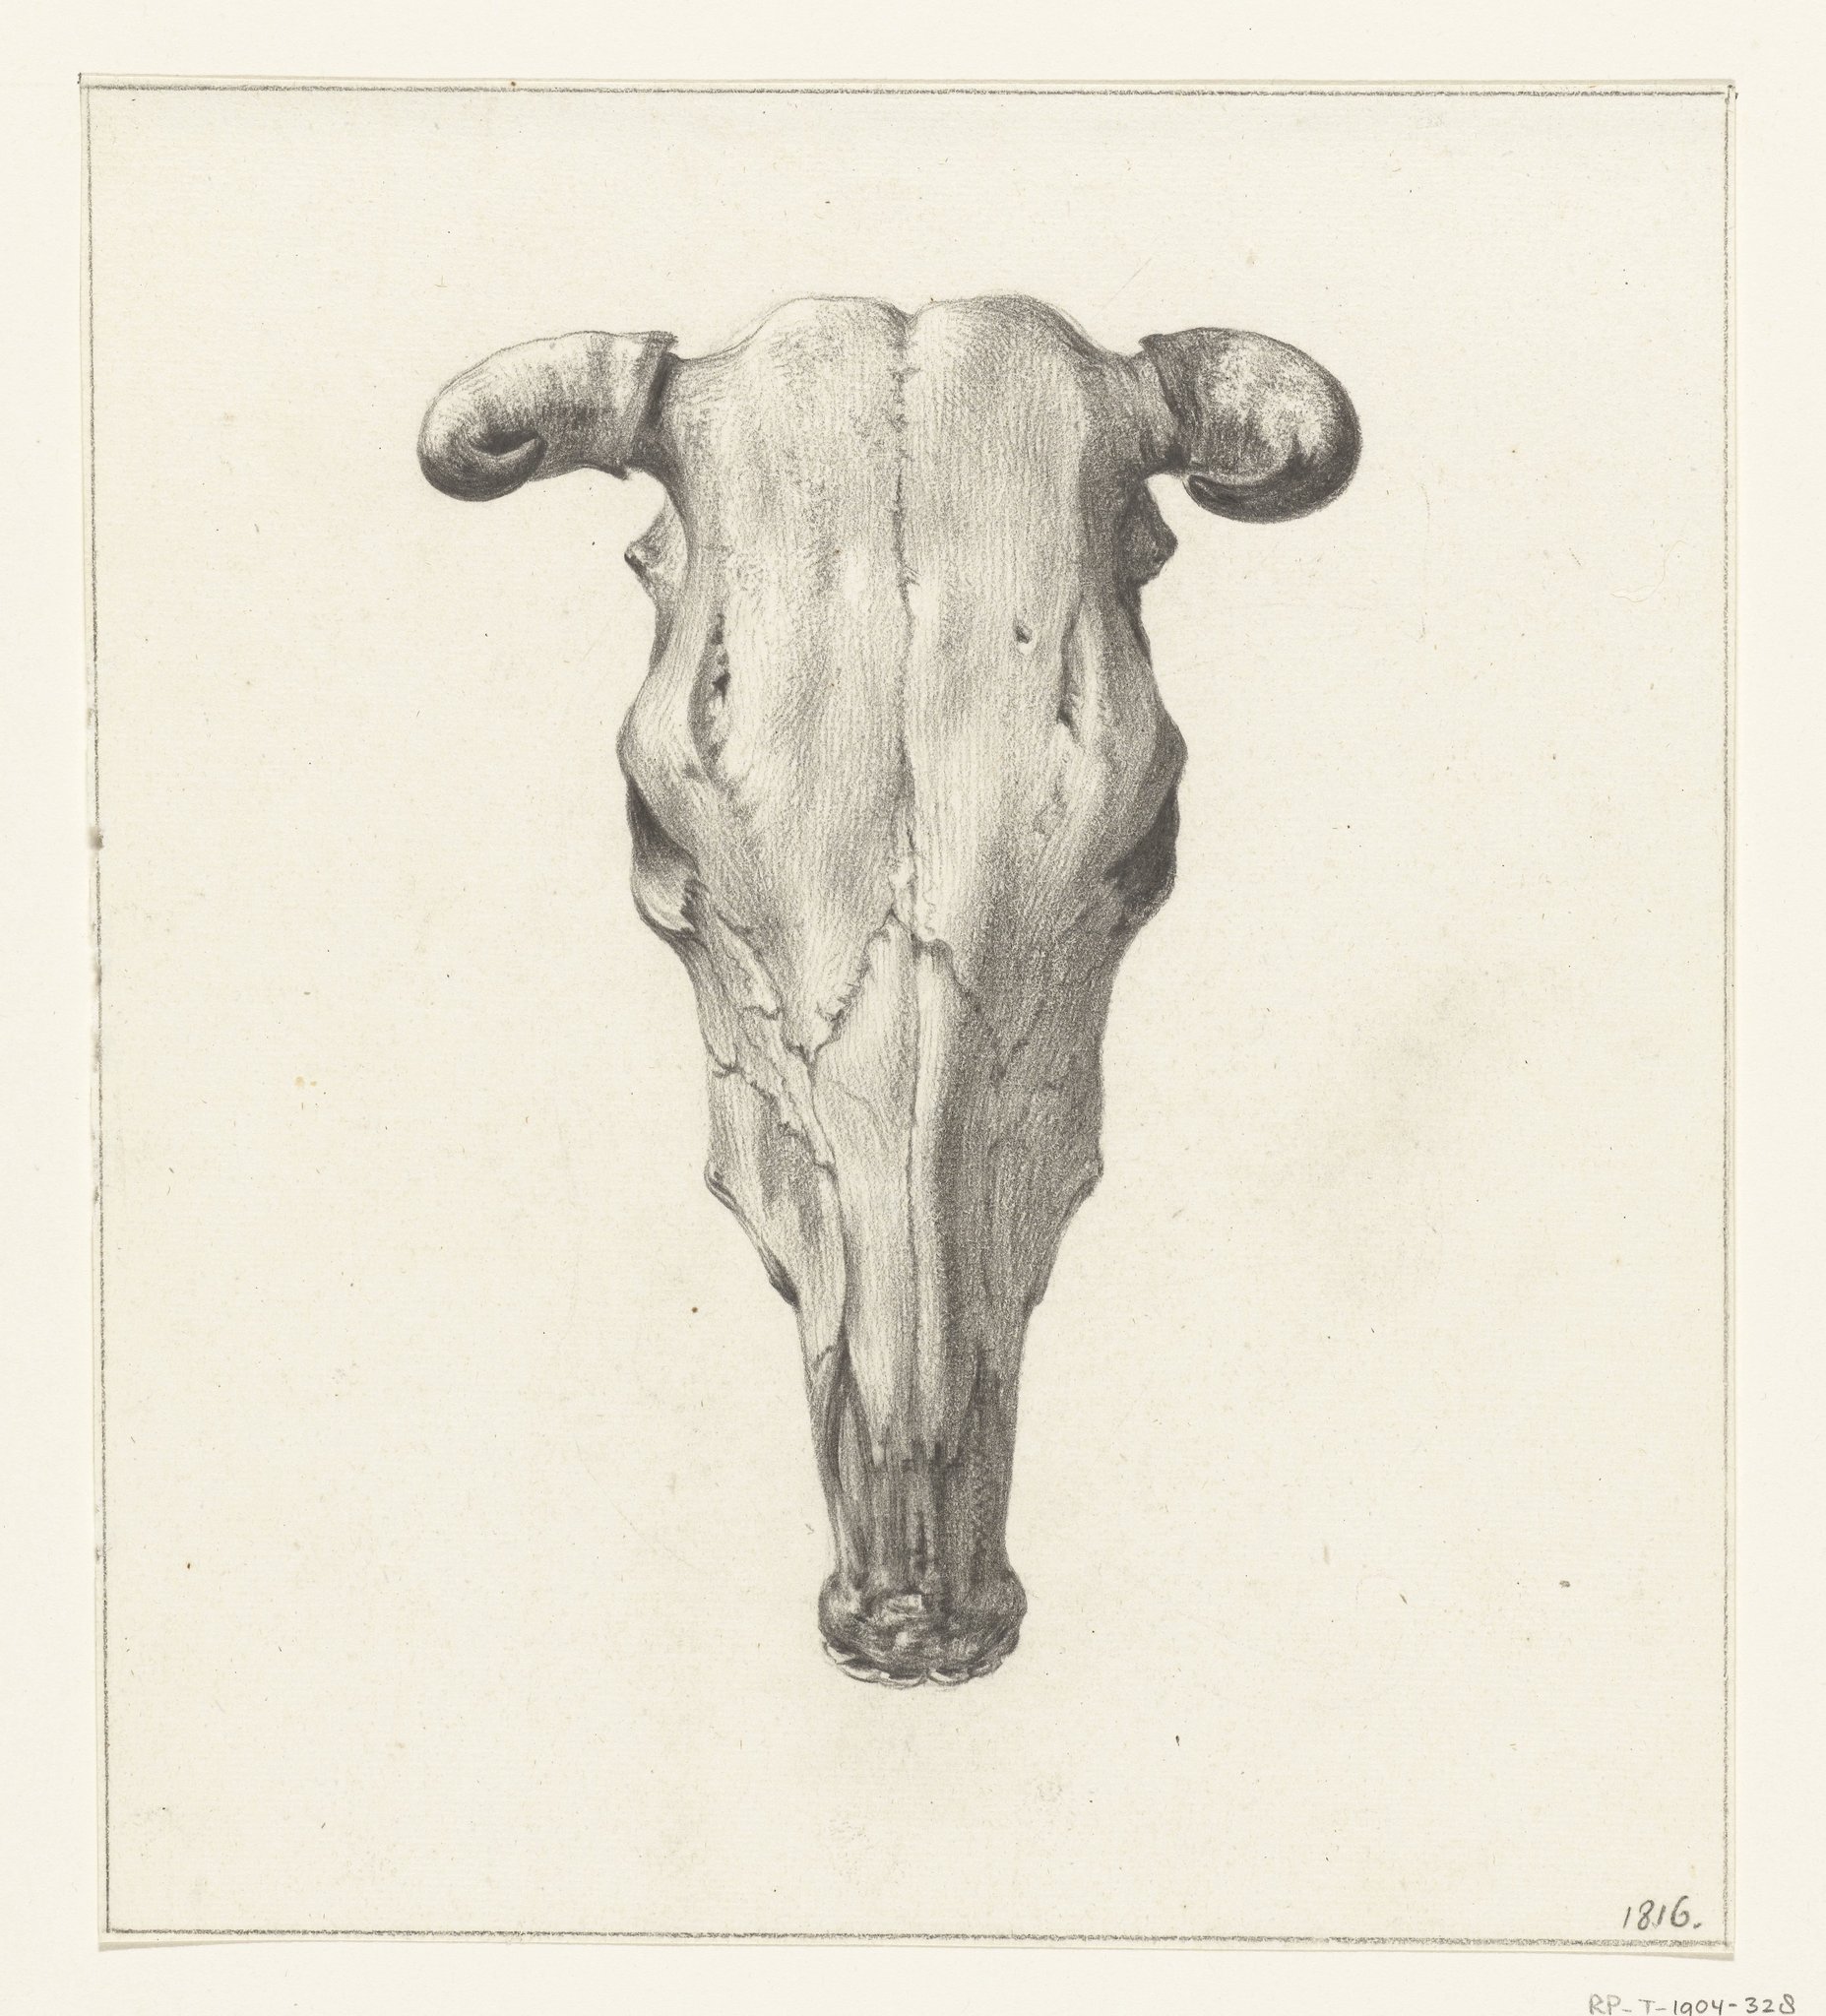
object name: drawing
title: Schedel van een koe, van boven gezien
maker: jean bernard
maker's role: draughtsman, print maker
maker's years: 1765-1833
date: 1816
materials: chalk, paper, pencil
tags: bovine cattle (+ skull of an animal)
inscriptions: date: ‘1816’